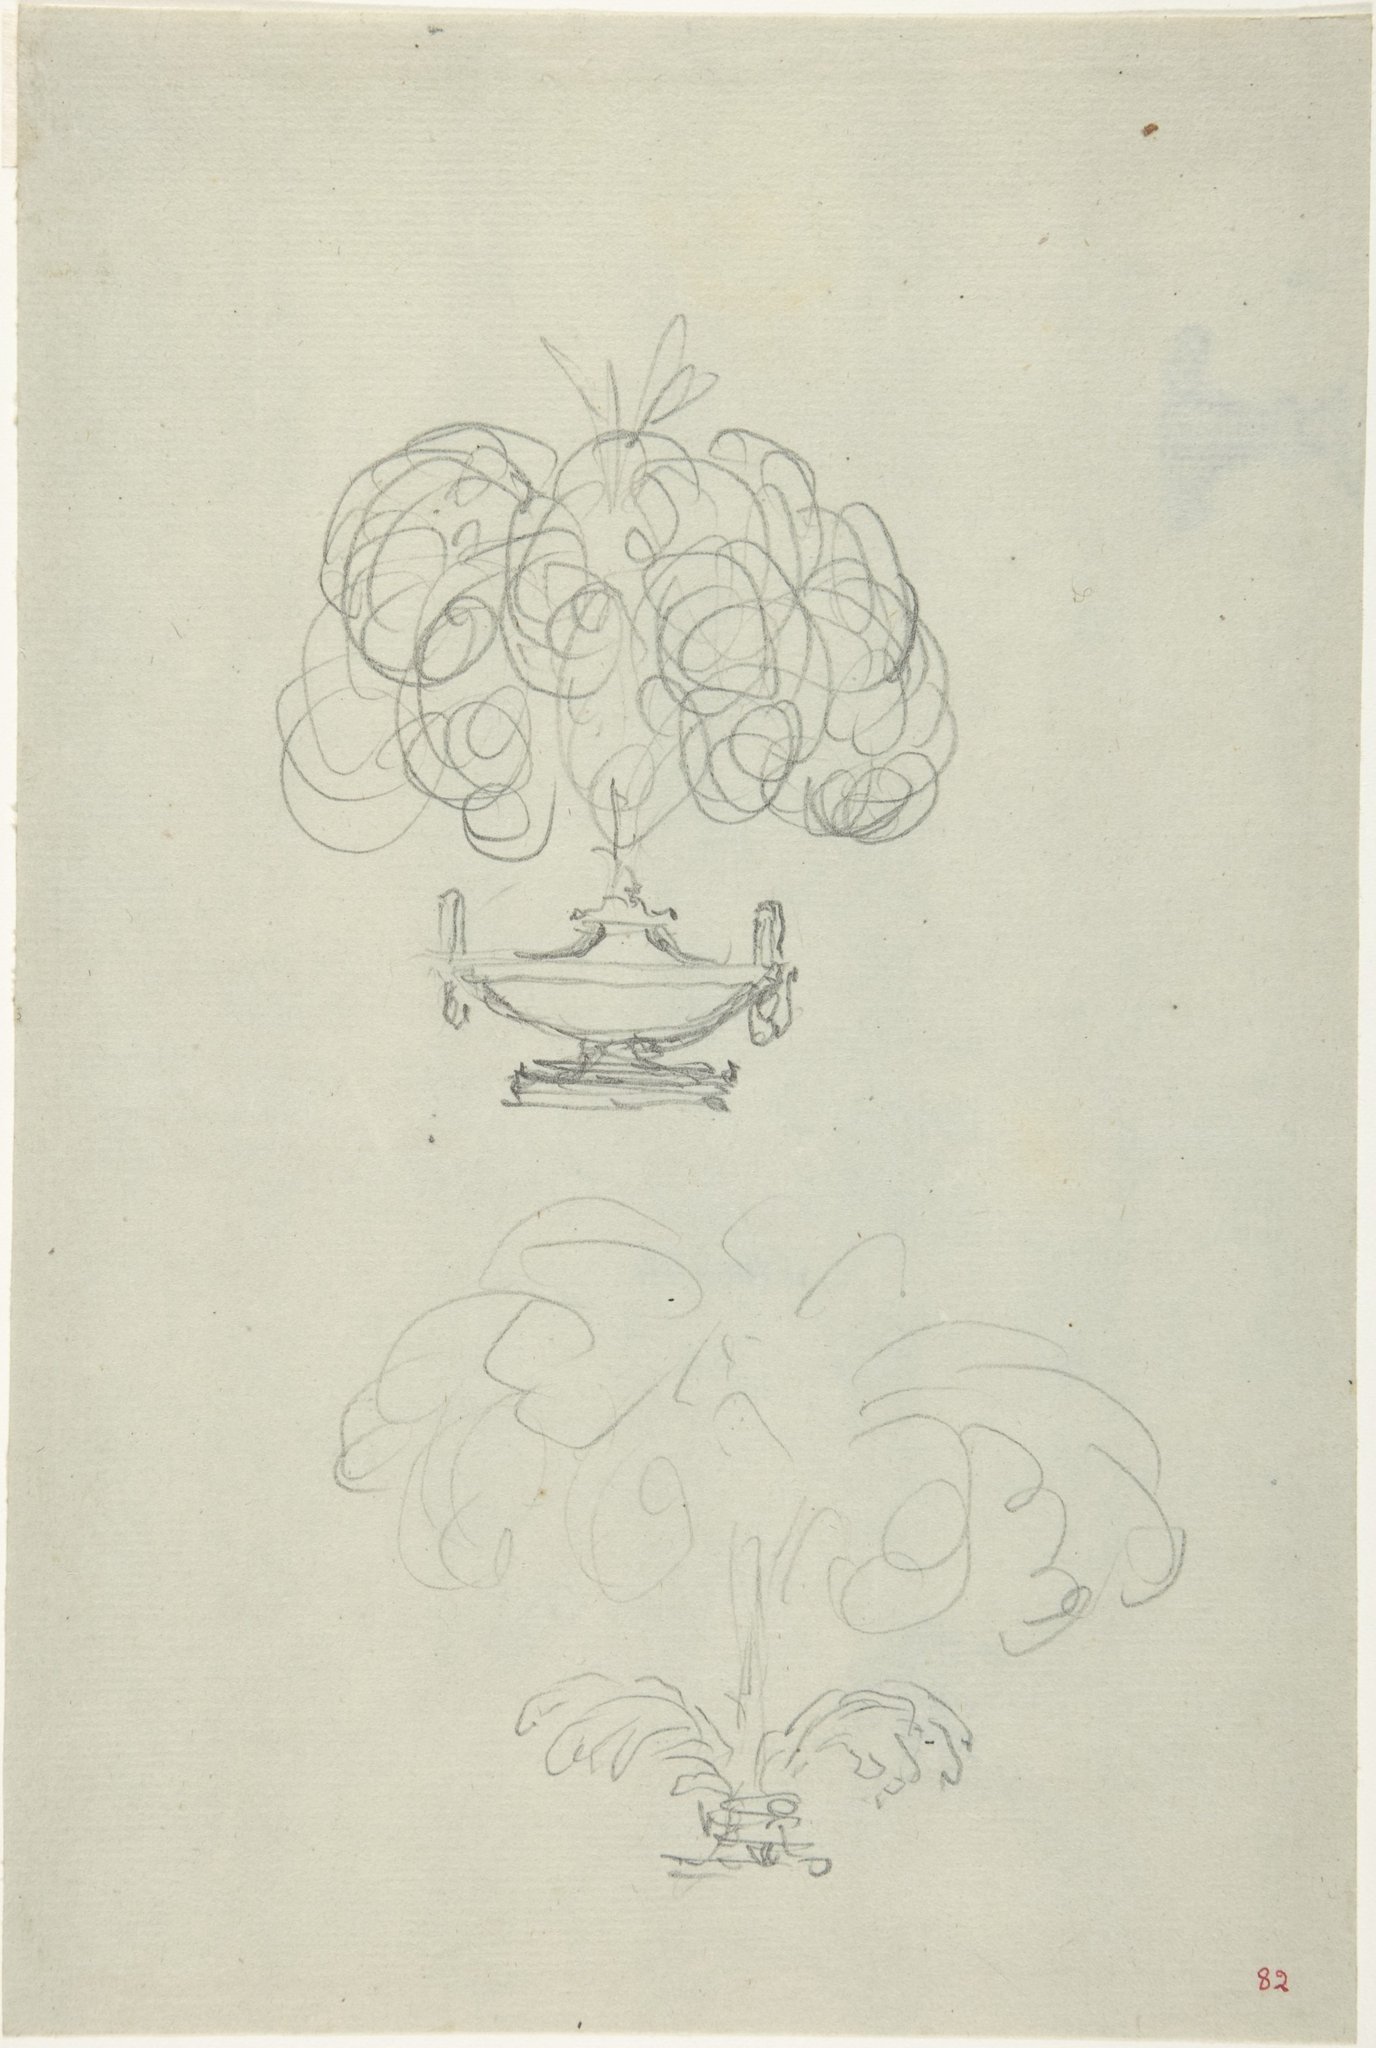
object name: drawing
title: Design for a Plumed Oil Lamp (recto); Sketches for a vase and oil lamp (verso)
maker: anonymous, french, 18th century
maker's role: artist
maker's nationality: french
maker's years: 1700-1800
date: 1770-1790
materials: graphite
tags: lamps